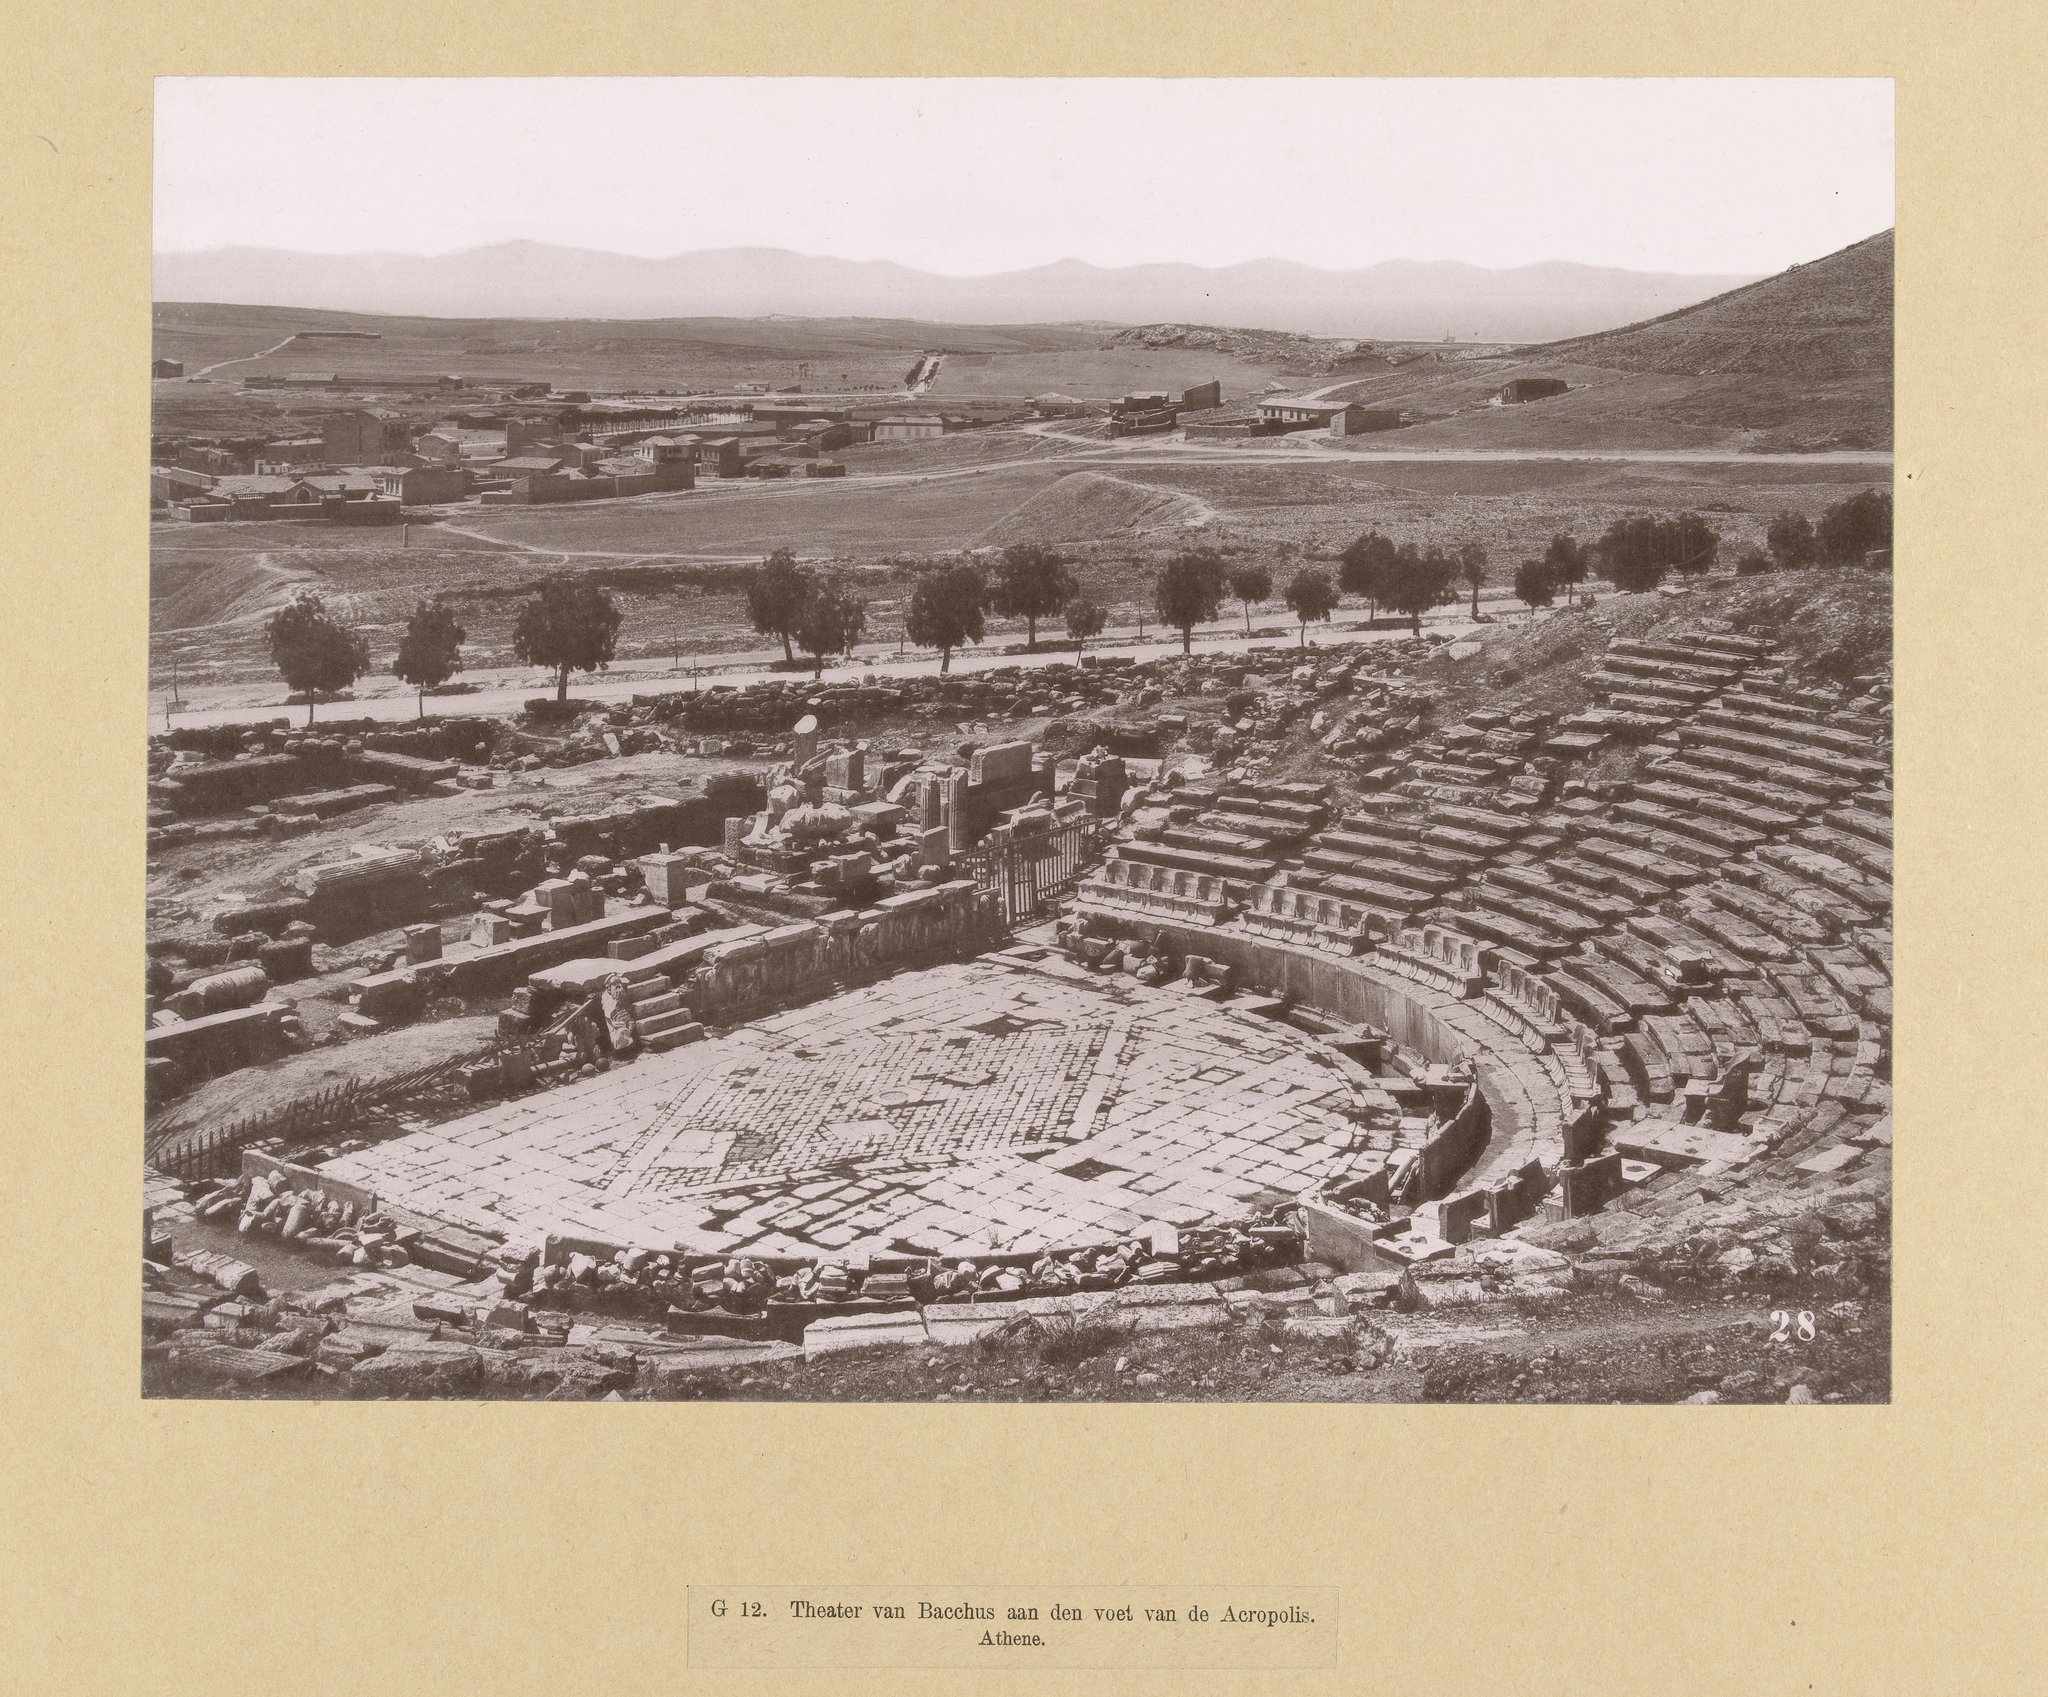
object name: photomechanical print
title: G 12. Theater van Bacchus aan den voet van de Acropolis. Athene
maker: Anonymous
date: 1890-1893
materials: cardboard, paper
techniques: photograph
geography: athens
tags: ruin of a building ~ architecture, amphitheatre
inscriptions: stamp: ‘Gemeentelijke bibliotheek/ Rotterdam’, title: ‘G 12. Theater van Bacchus aan den voet van de Acropolis./ Athene.’, check stamp: ‘Bristol/ L.M.’, number: ‘28’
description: Onderdeel van een groep door fotograaf Richard Polak op reis verzamelde foto’s. Deze fotomechanische afdruk is samen met andere op zijn reizen verzamelde foto's tentoongesteld bij de Rotterdamsche Kunstkring (1895), Arti en Amicitiae te Amsterdam (1897-1898?) en Societeit 't Collegie te Kampen (datum vooralsnog onbekend).